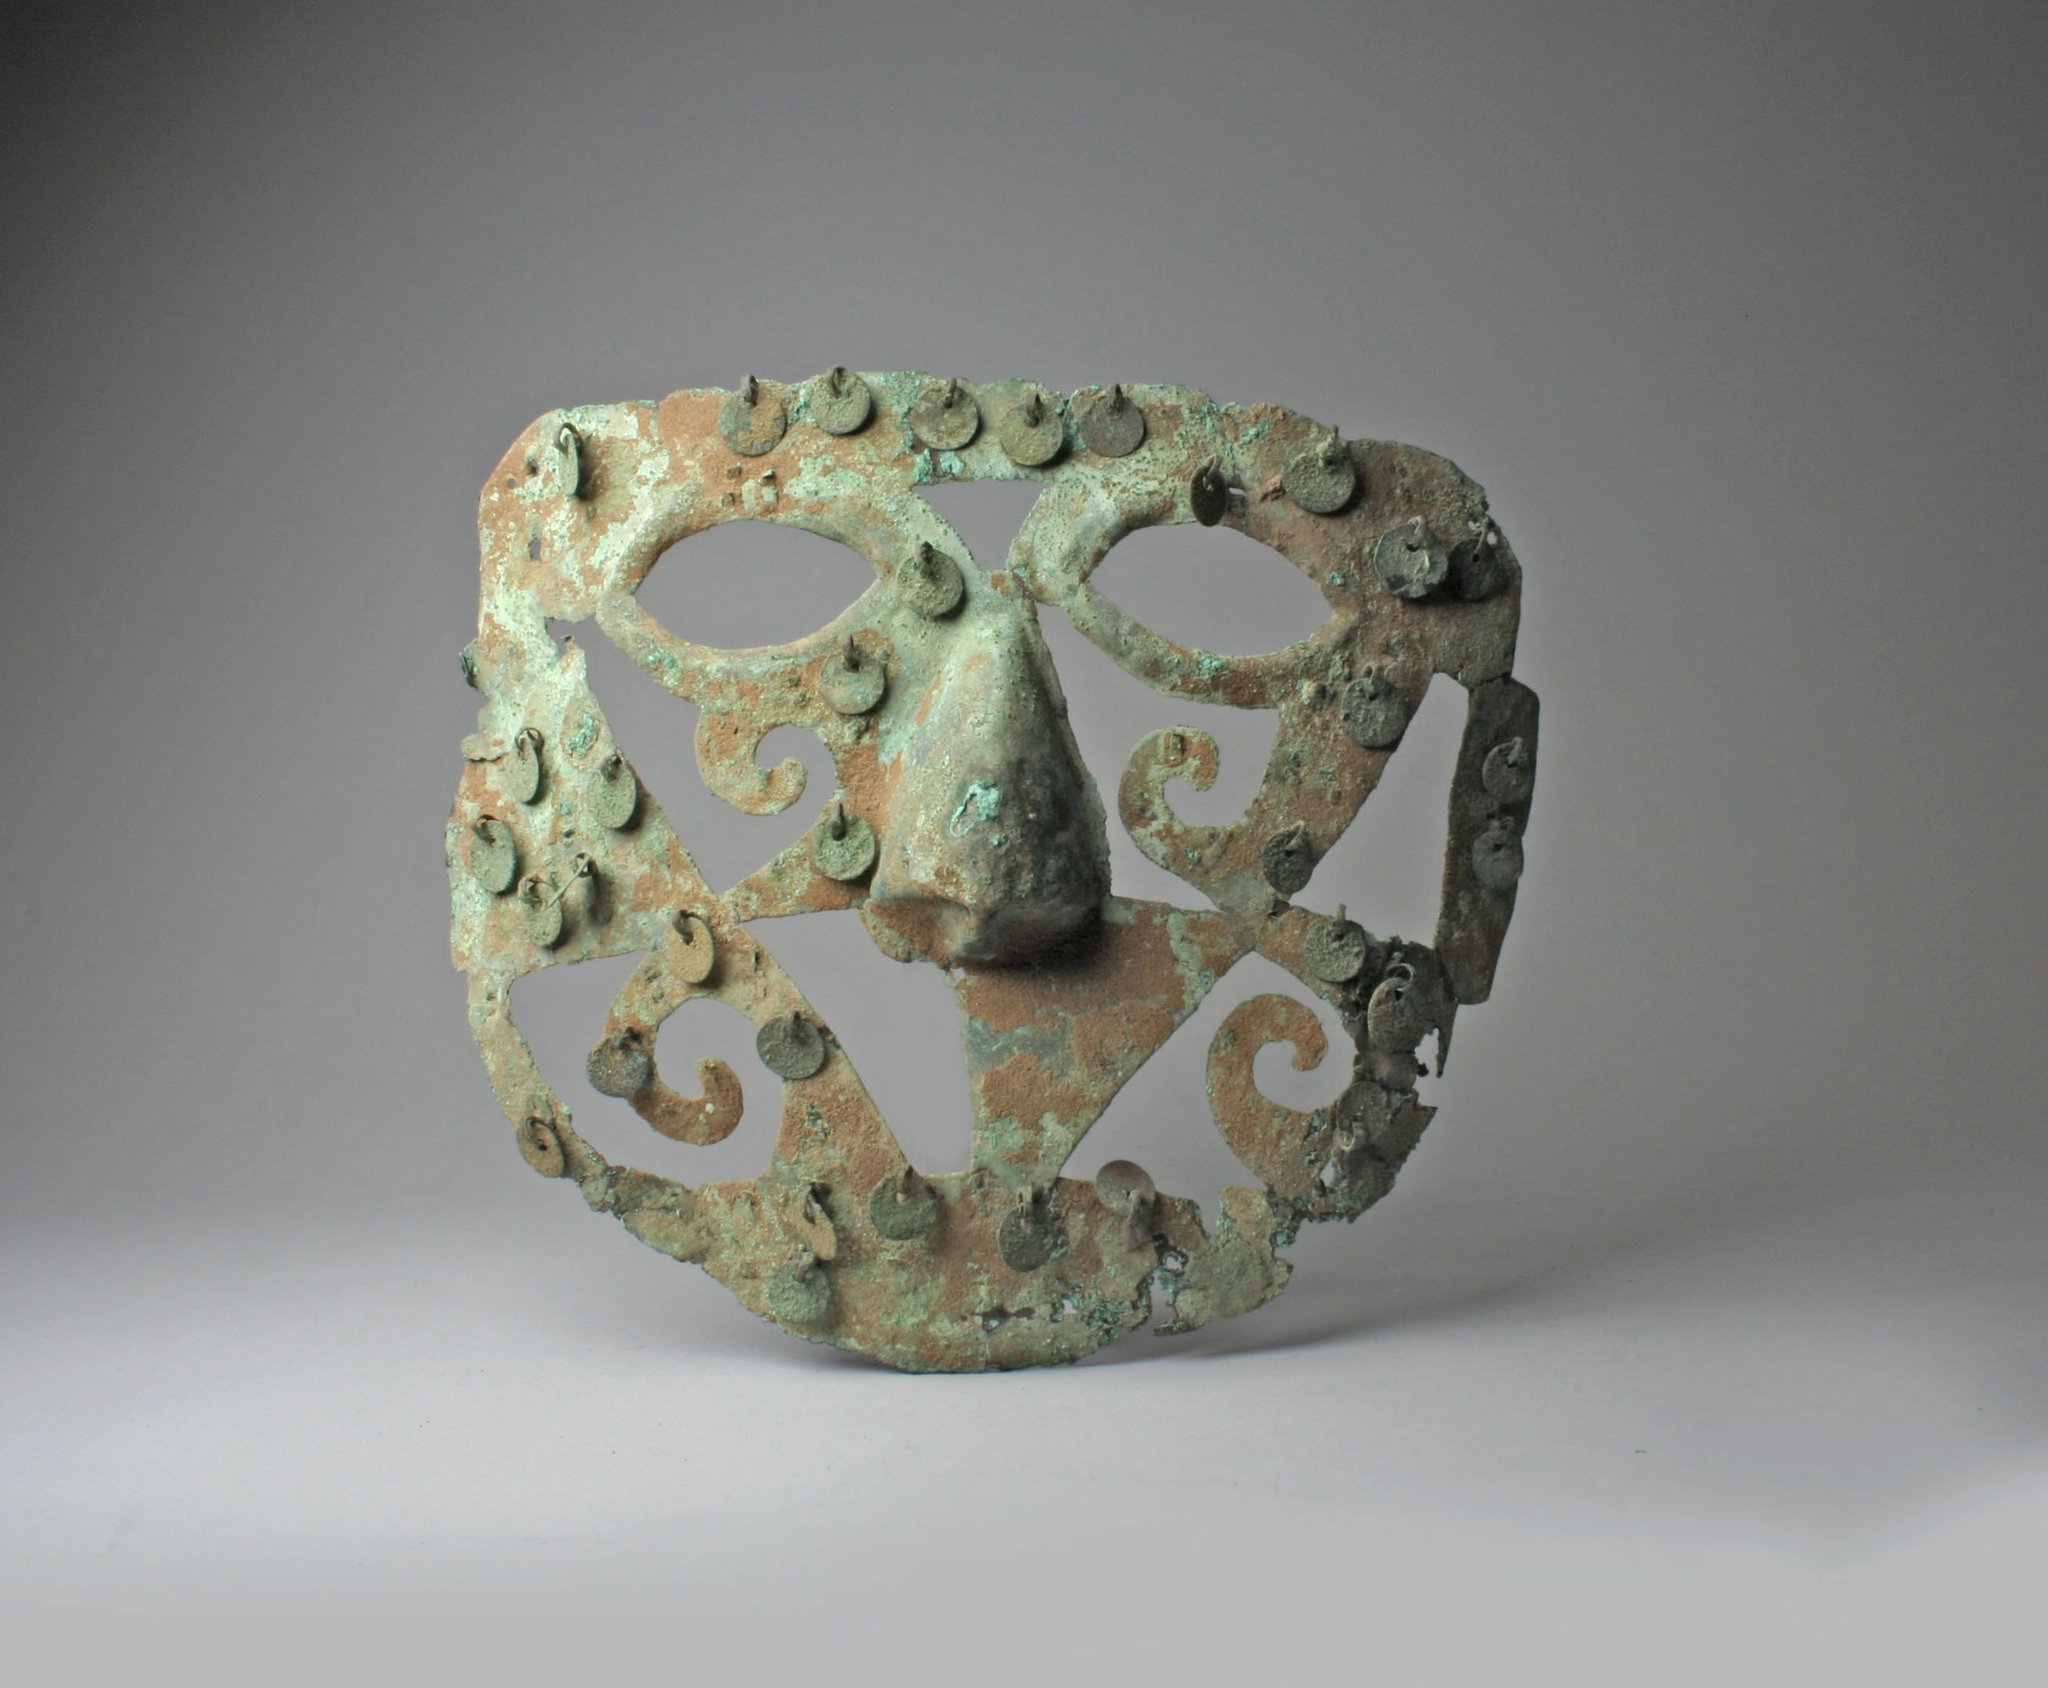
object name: ornament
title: Face Mask Ornament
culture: moche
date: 501-700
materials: gilt copper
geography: peru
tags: masks